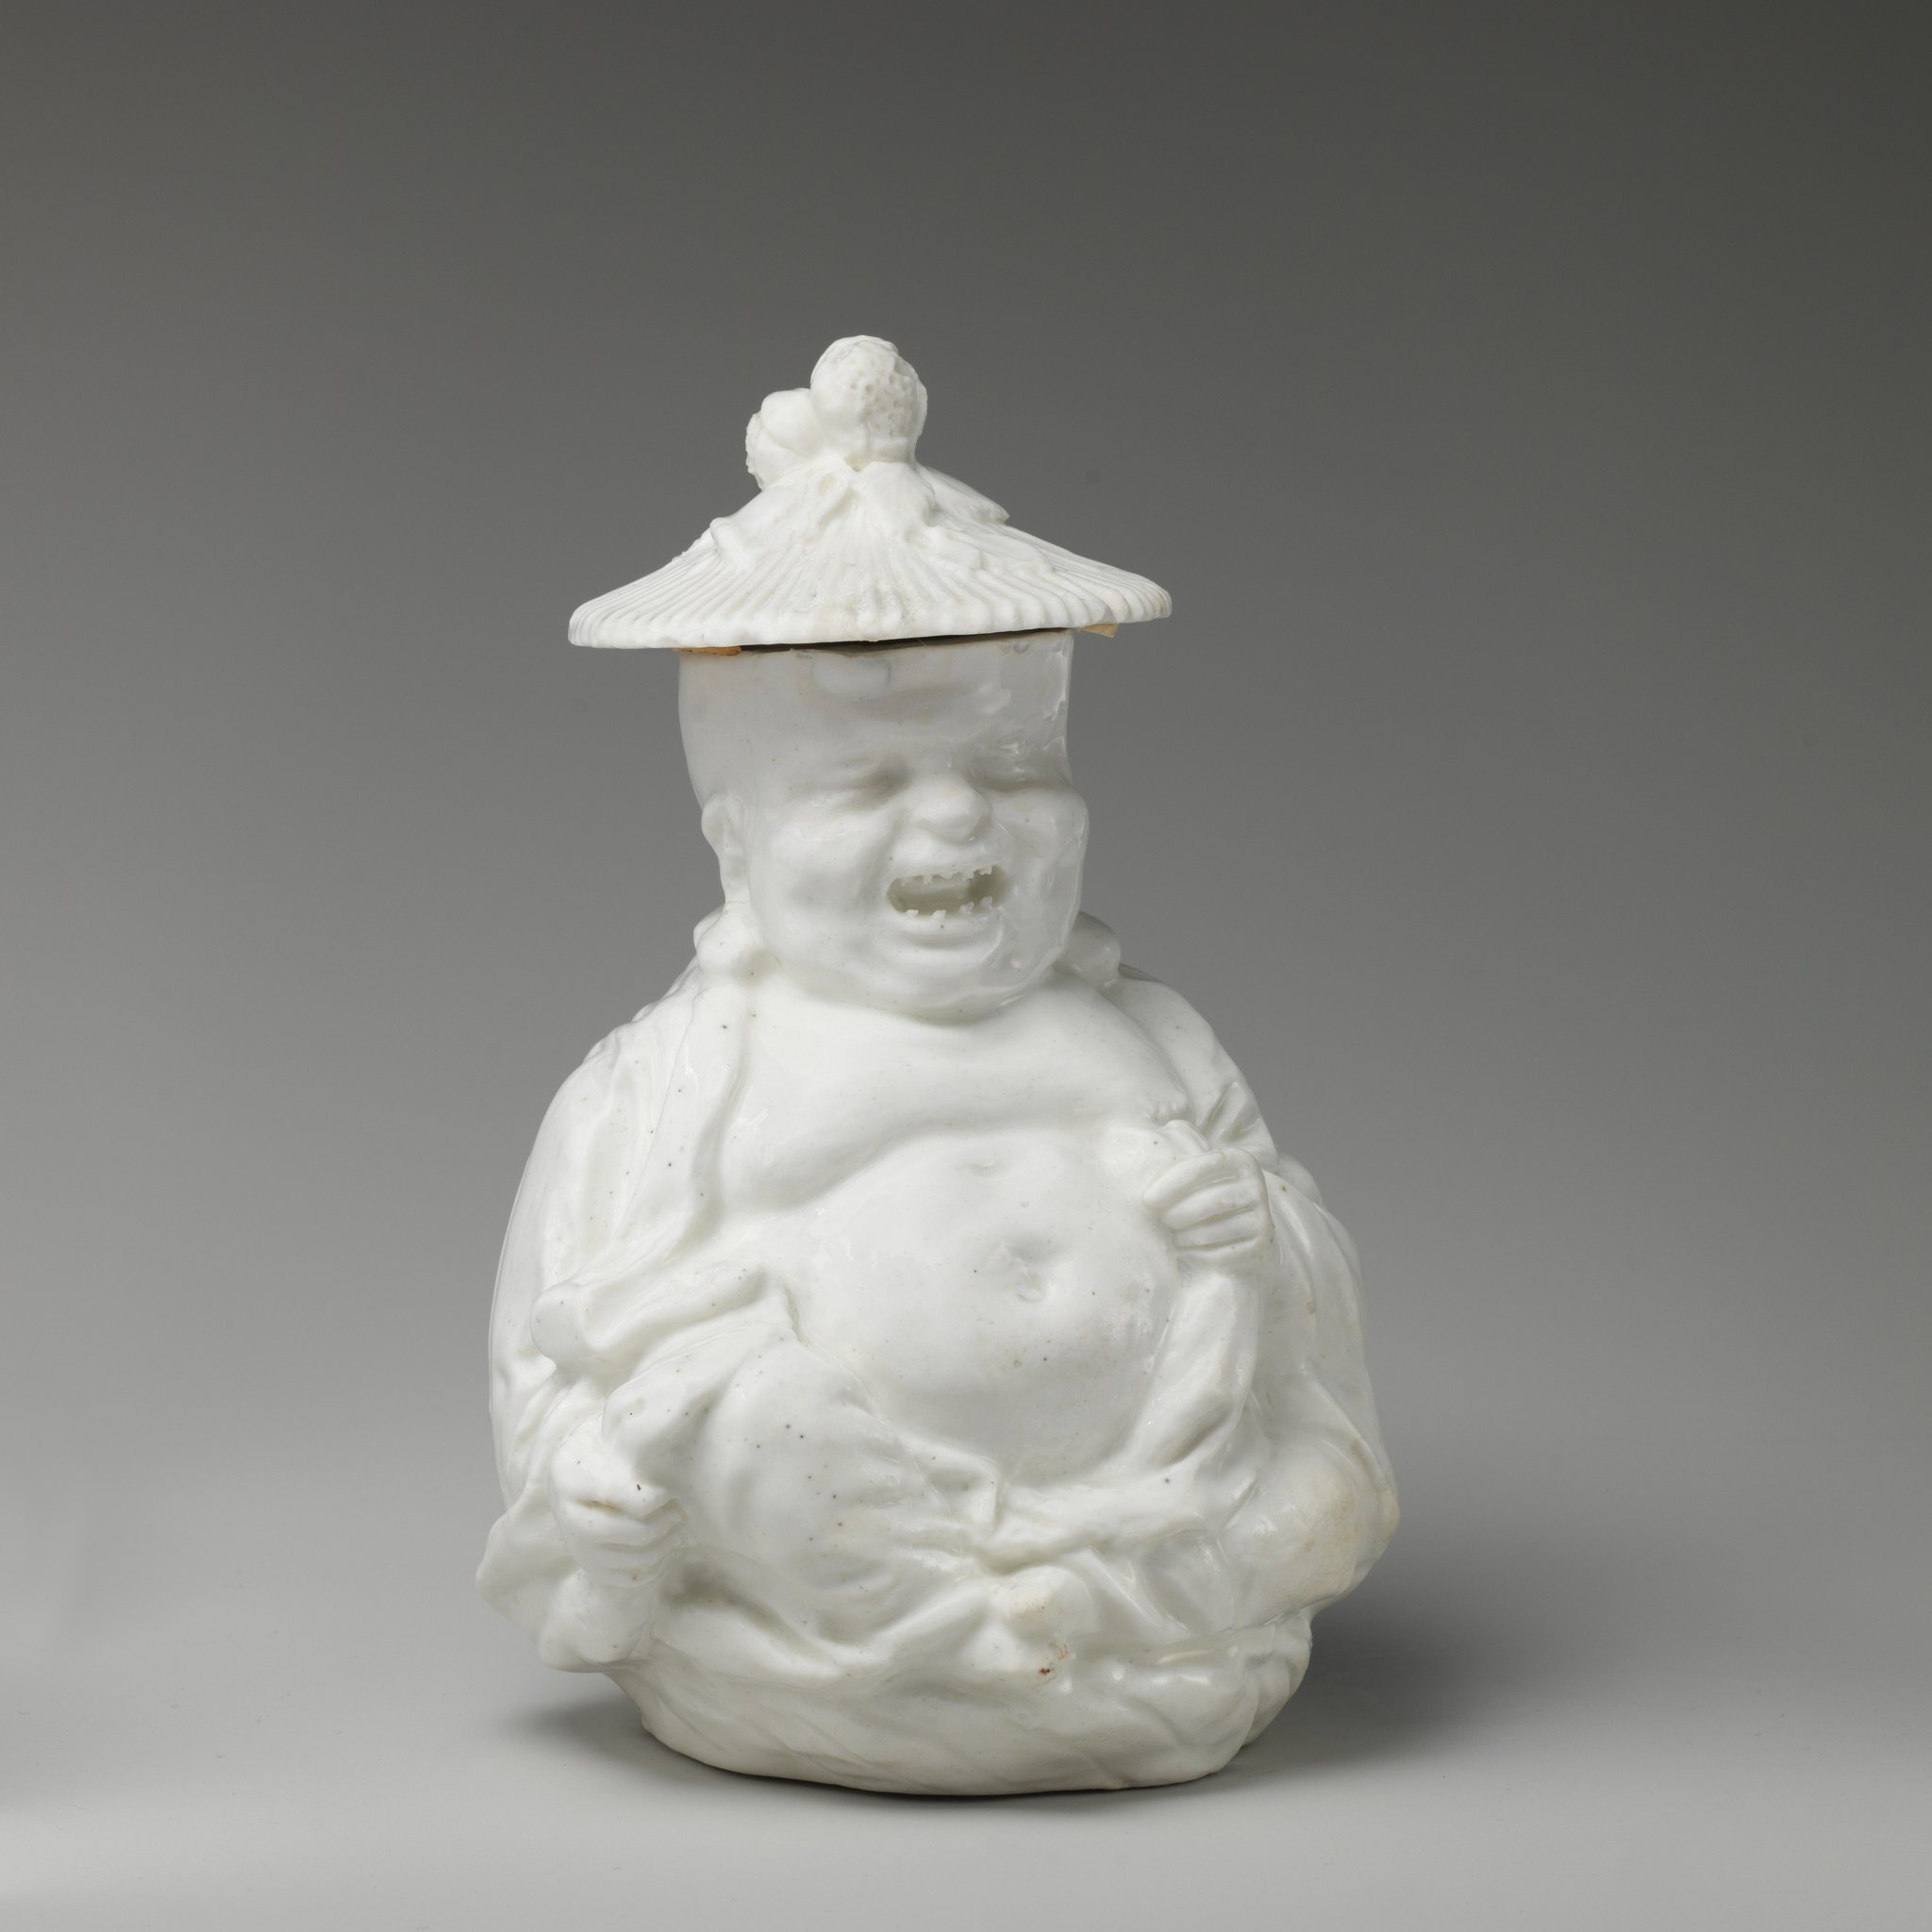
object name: tea caddy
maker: chelsea porcelain manufactory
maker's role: factory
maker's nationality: british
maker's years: 1744-1784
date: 1745-1750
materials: soft paste porcelain